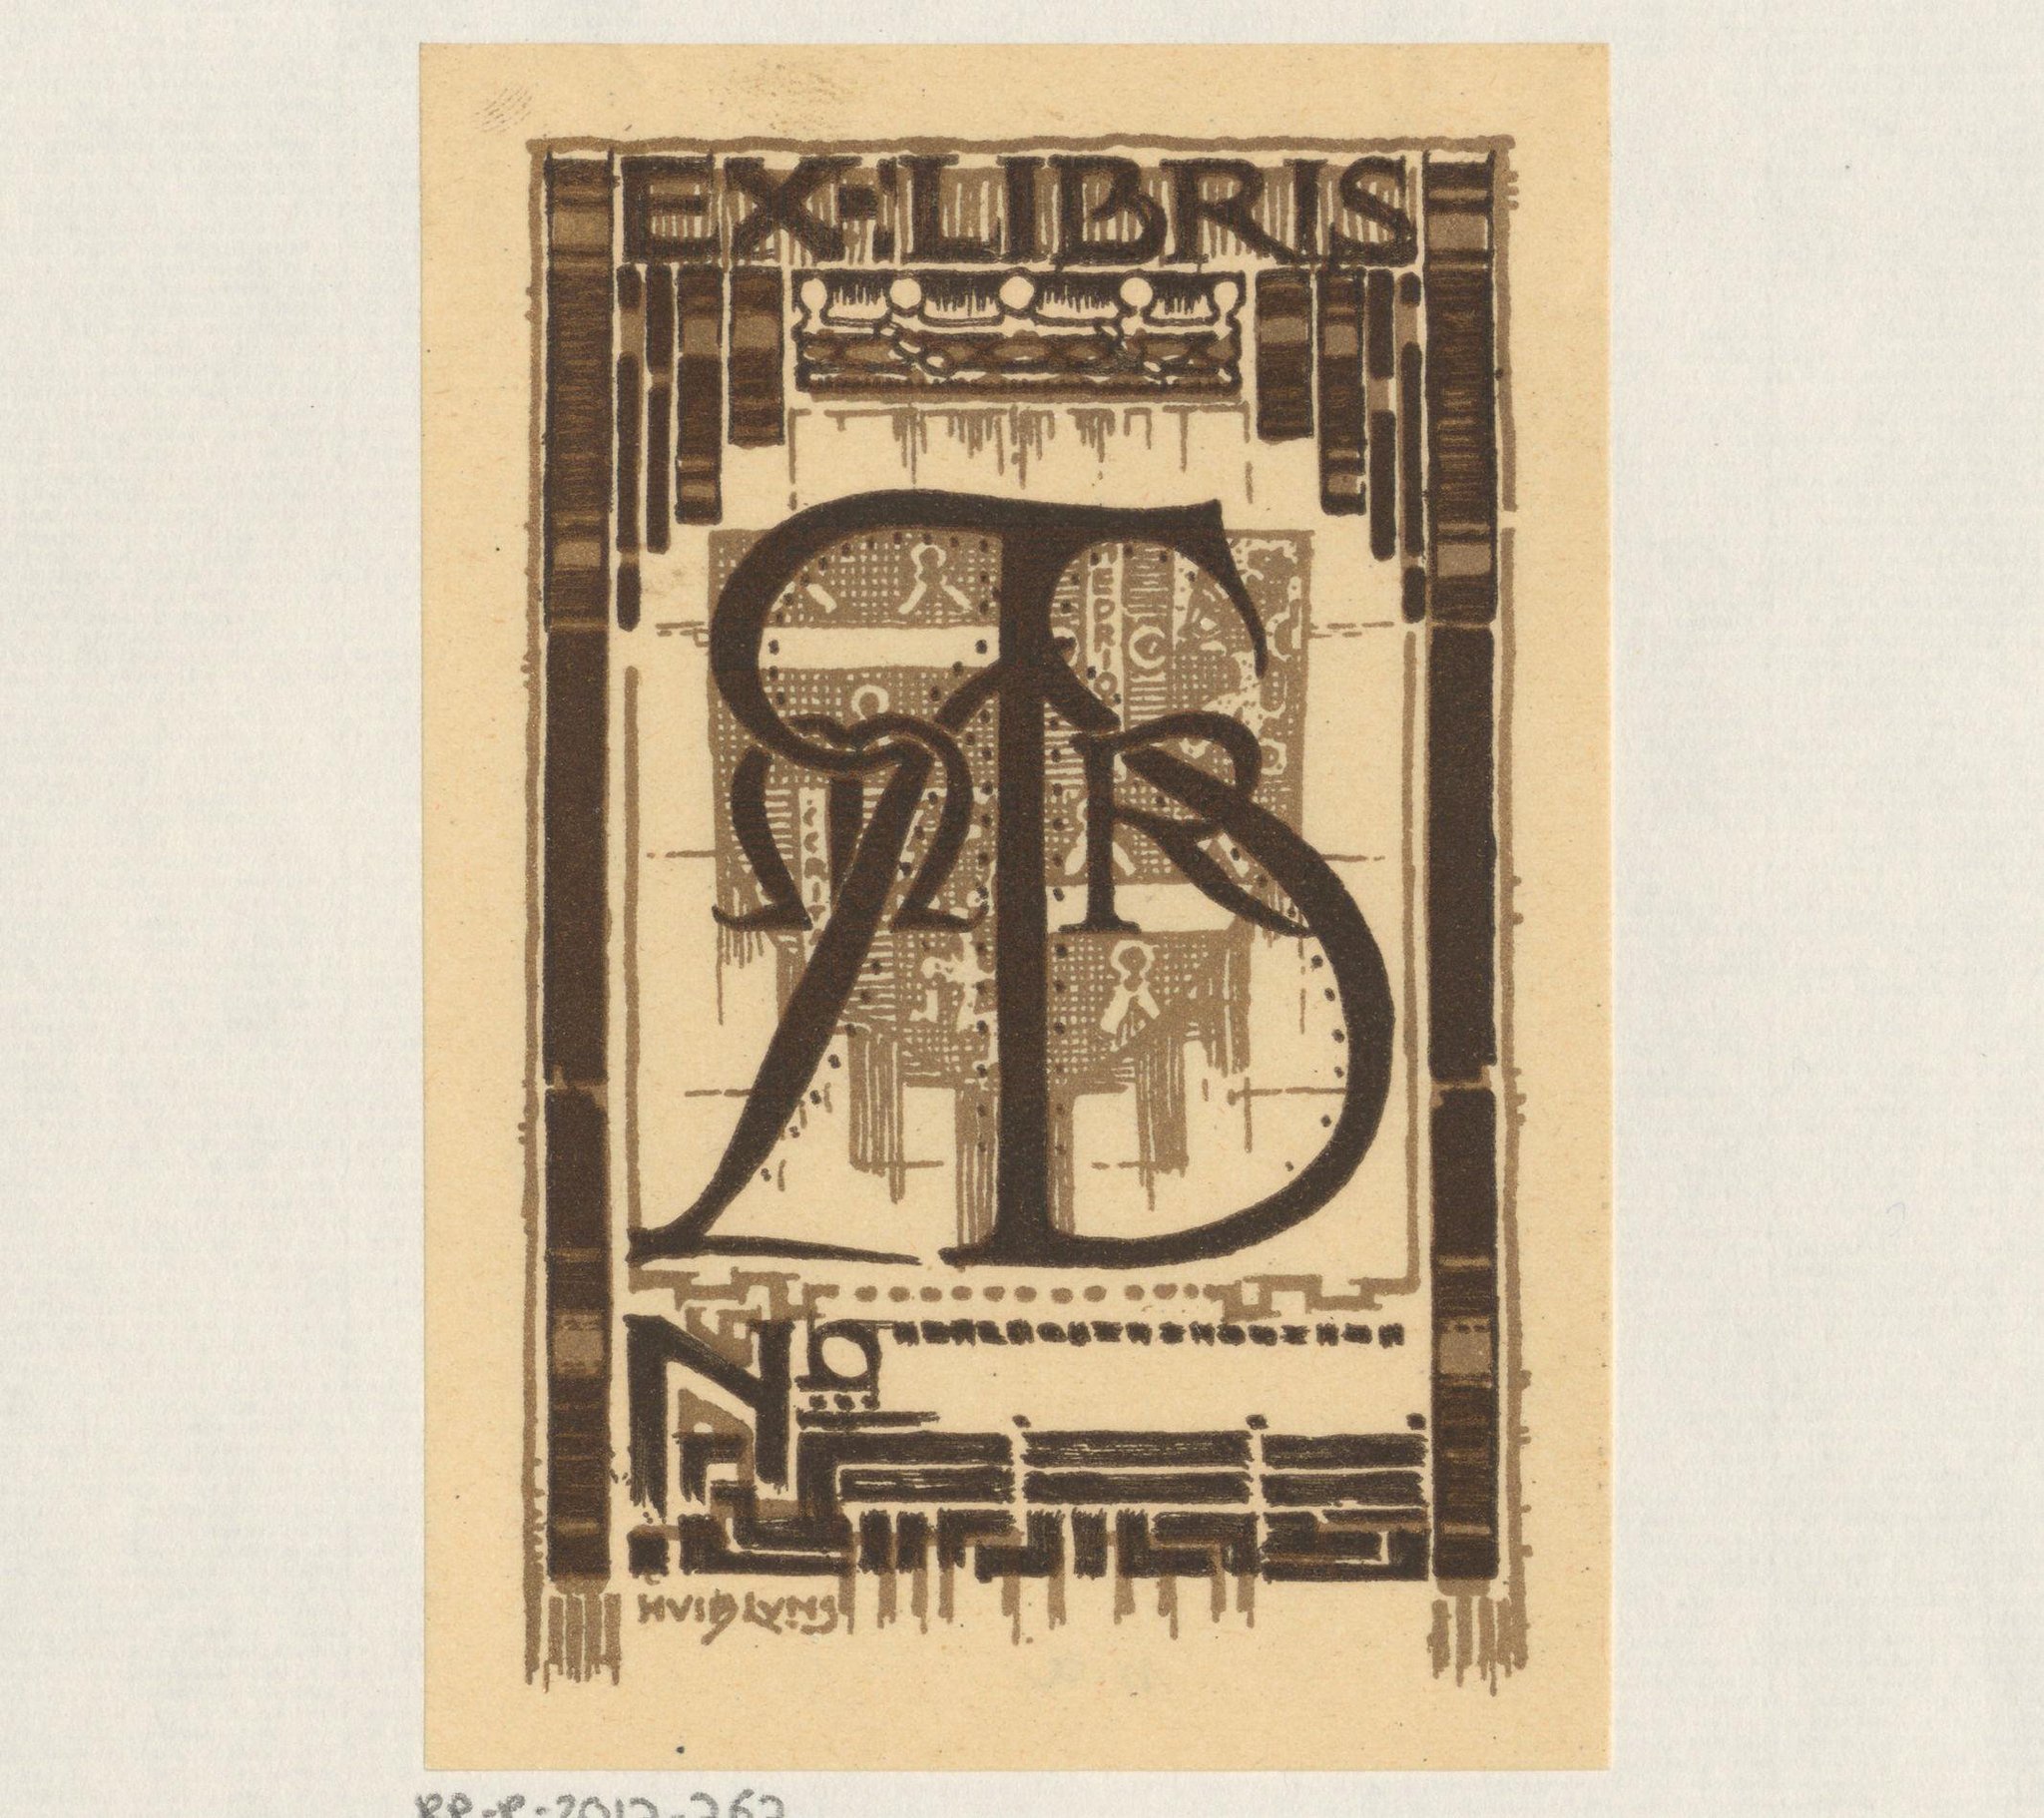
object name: bookplate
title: Ex libris van M.R.R.S.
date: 1891-1941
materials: paper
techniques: printing block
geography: netherlands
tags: utrecht, book